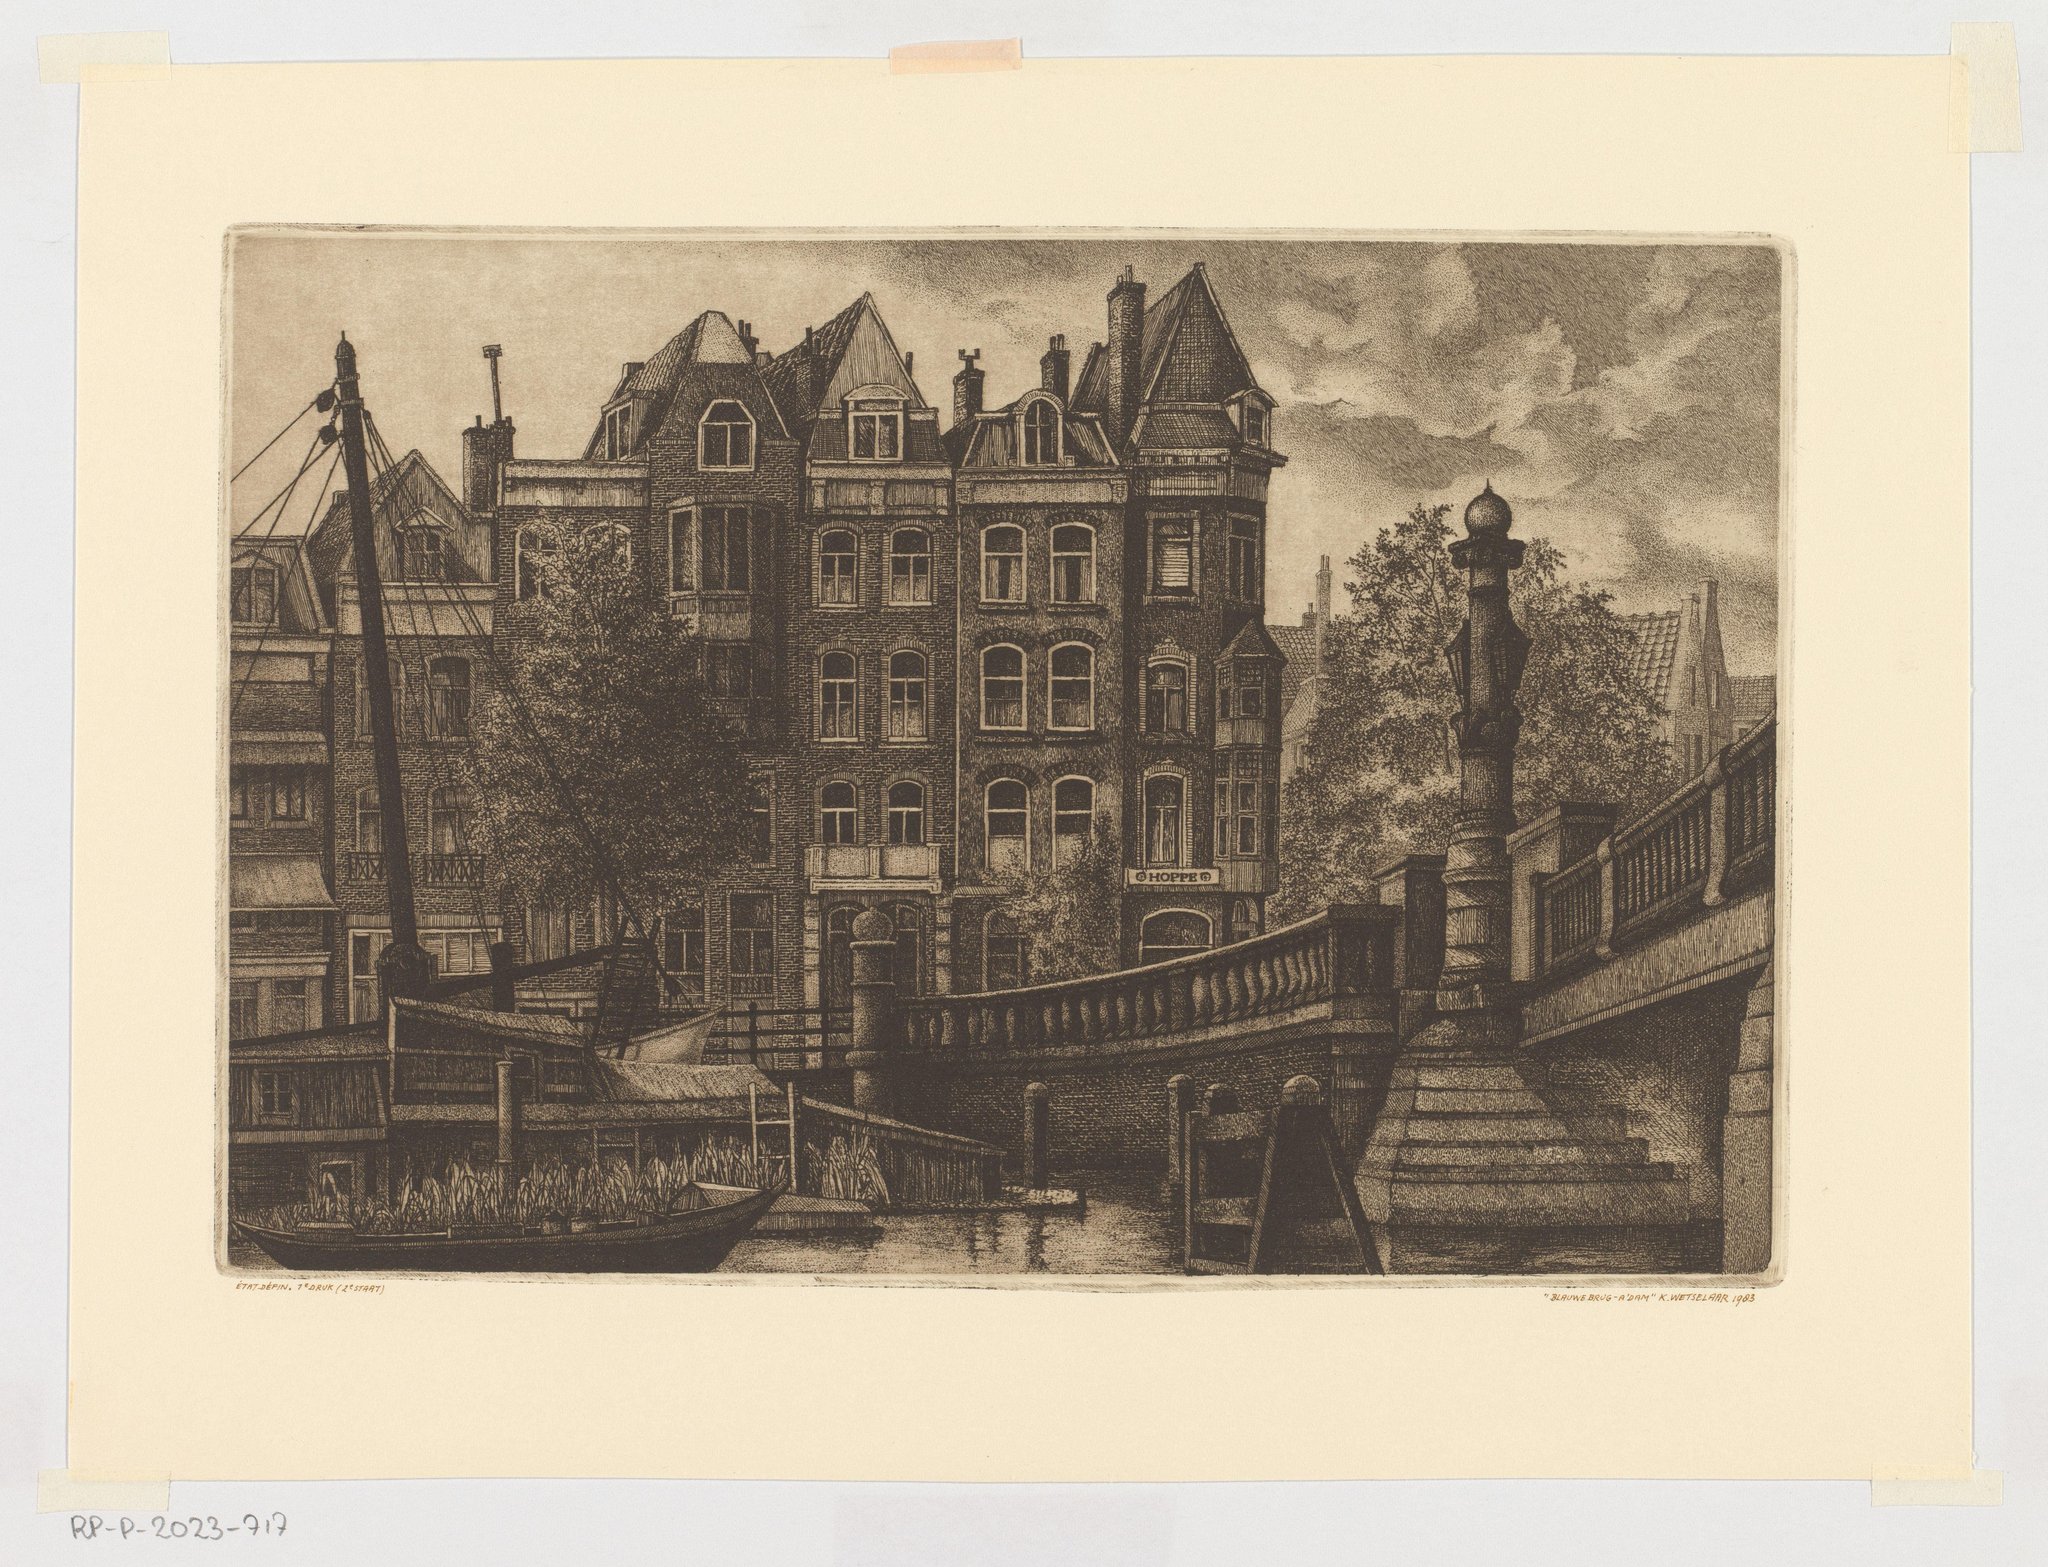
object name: print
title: Blauwe Brug - A'dam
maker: karel wetselaar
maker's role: print maker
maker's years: 1935-2017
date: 1983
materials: paper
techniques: aquatint, etching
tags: bridge in city across river, canal, etc., amsterdam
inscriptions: inscription: ‘état défin. 1e druk (2e staat)’, signature and date: ‘K. Wetselaar 1983’